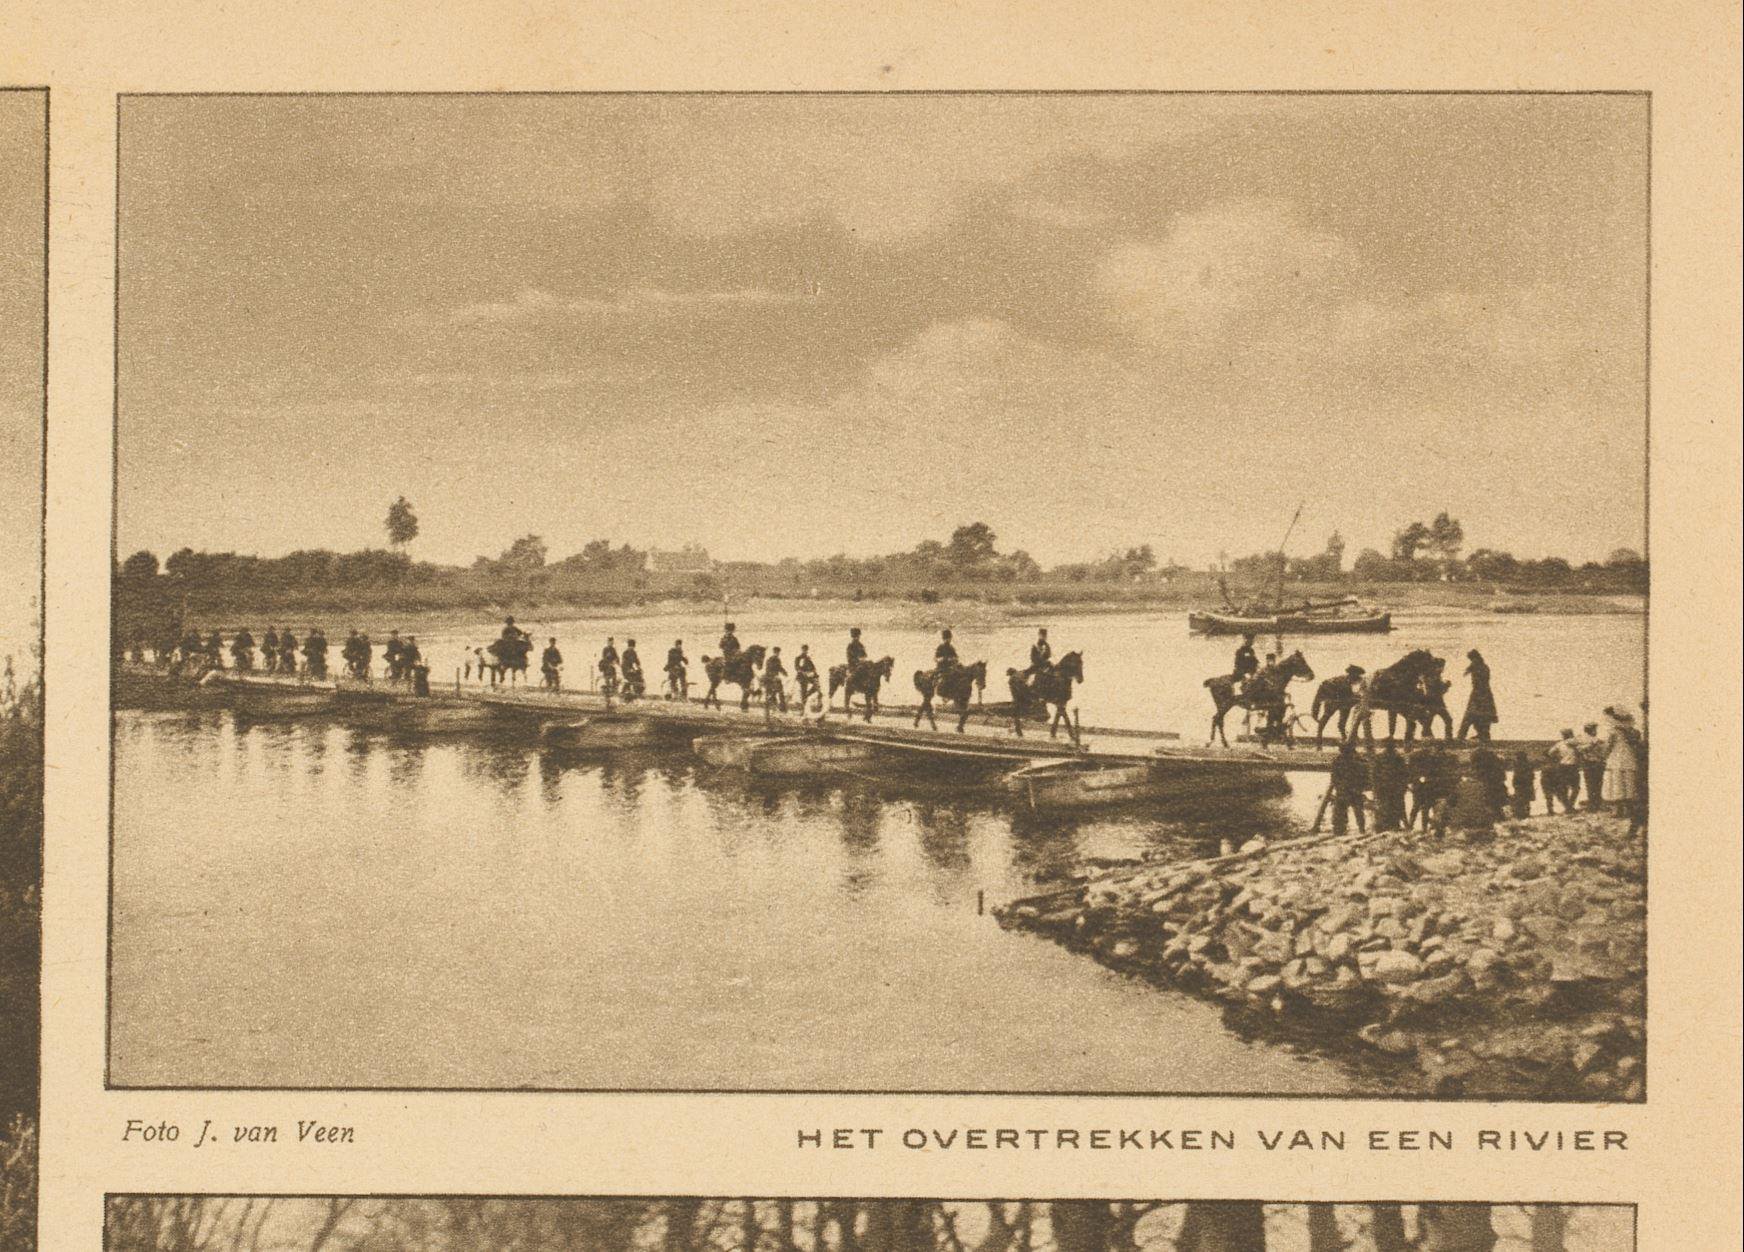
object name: album leaf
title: Het overtrekken van een rivier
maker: j. van veen (fotograaf)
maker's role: fotograaf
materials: paper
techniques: rotogravure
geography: leiden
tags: crossing a river, military training, netherlands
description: Deze prent maakt deel uit van een album.